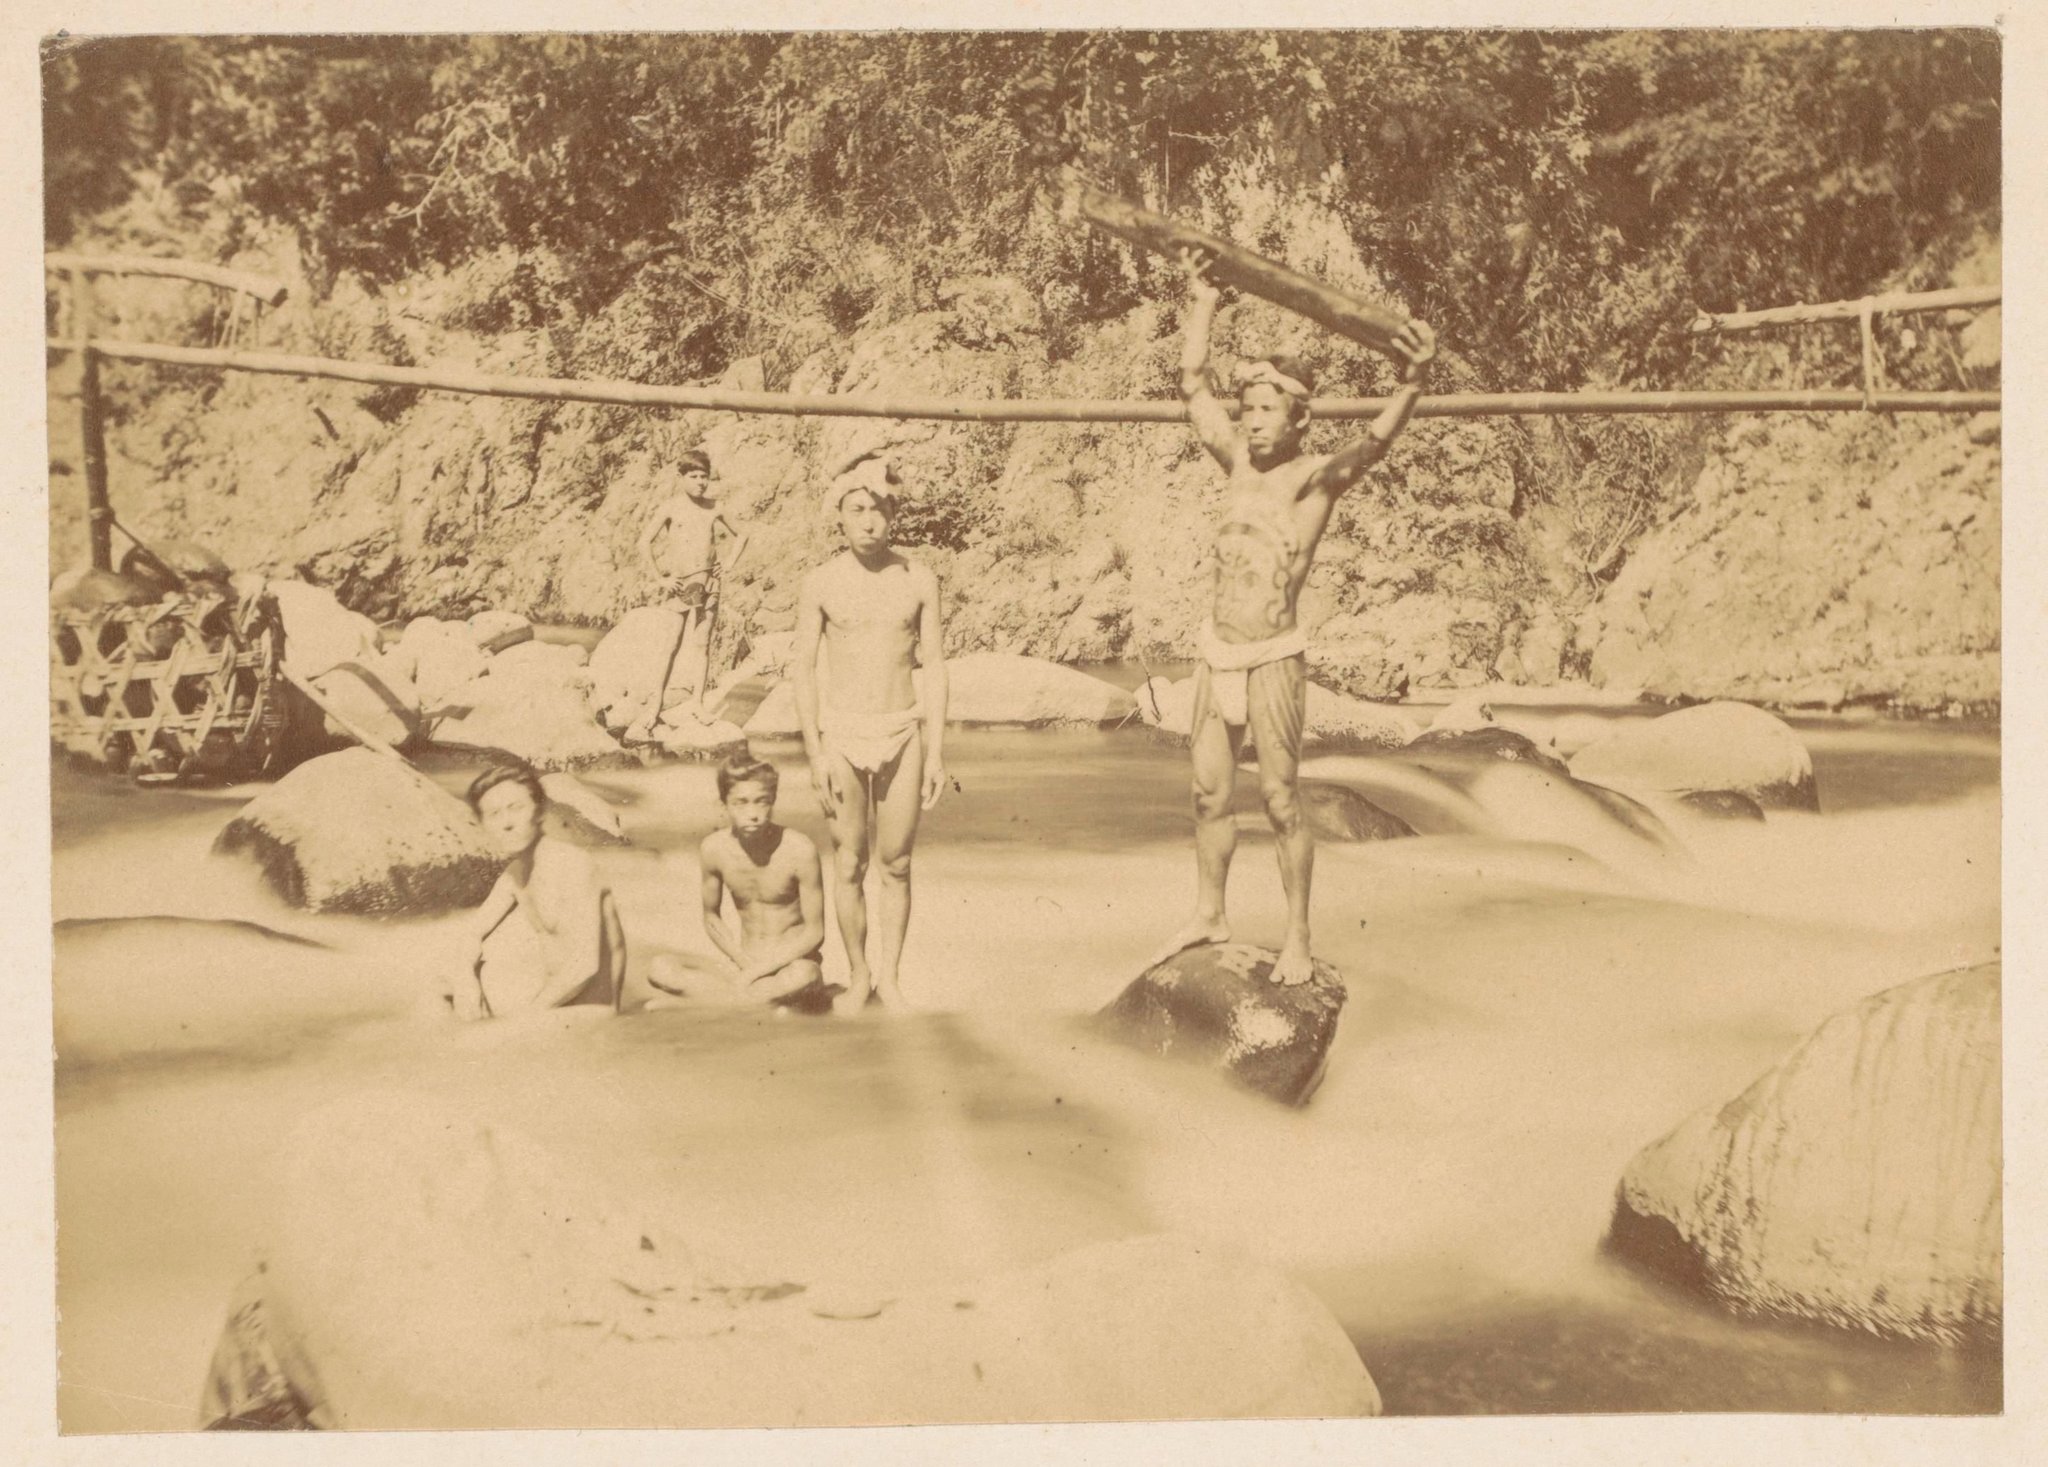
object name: photograph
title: Japan 1884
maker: Anonymous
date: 1884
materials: cardboard, paper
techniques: albumen print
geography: japan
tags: river, youth, adolescent, japan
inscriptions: inscription: ‘[onleesbaar]’